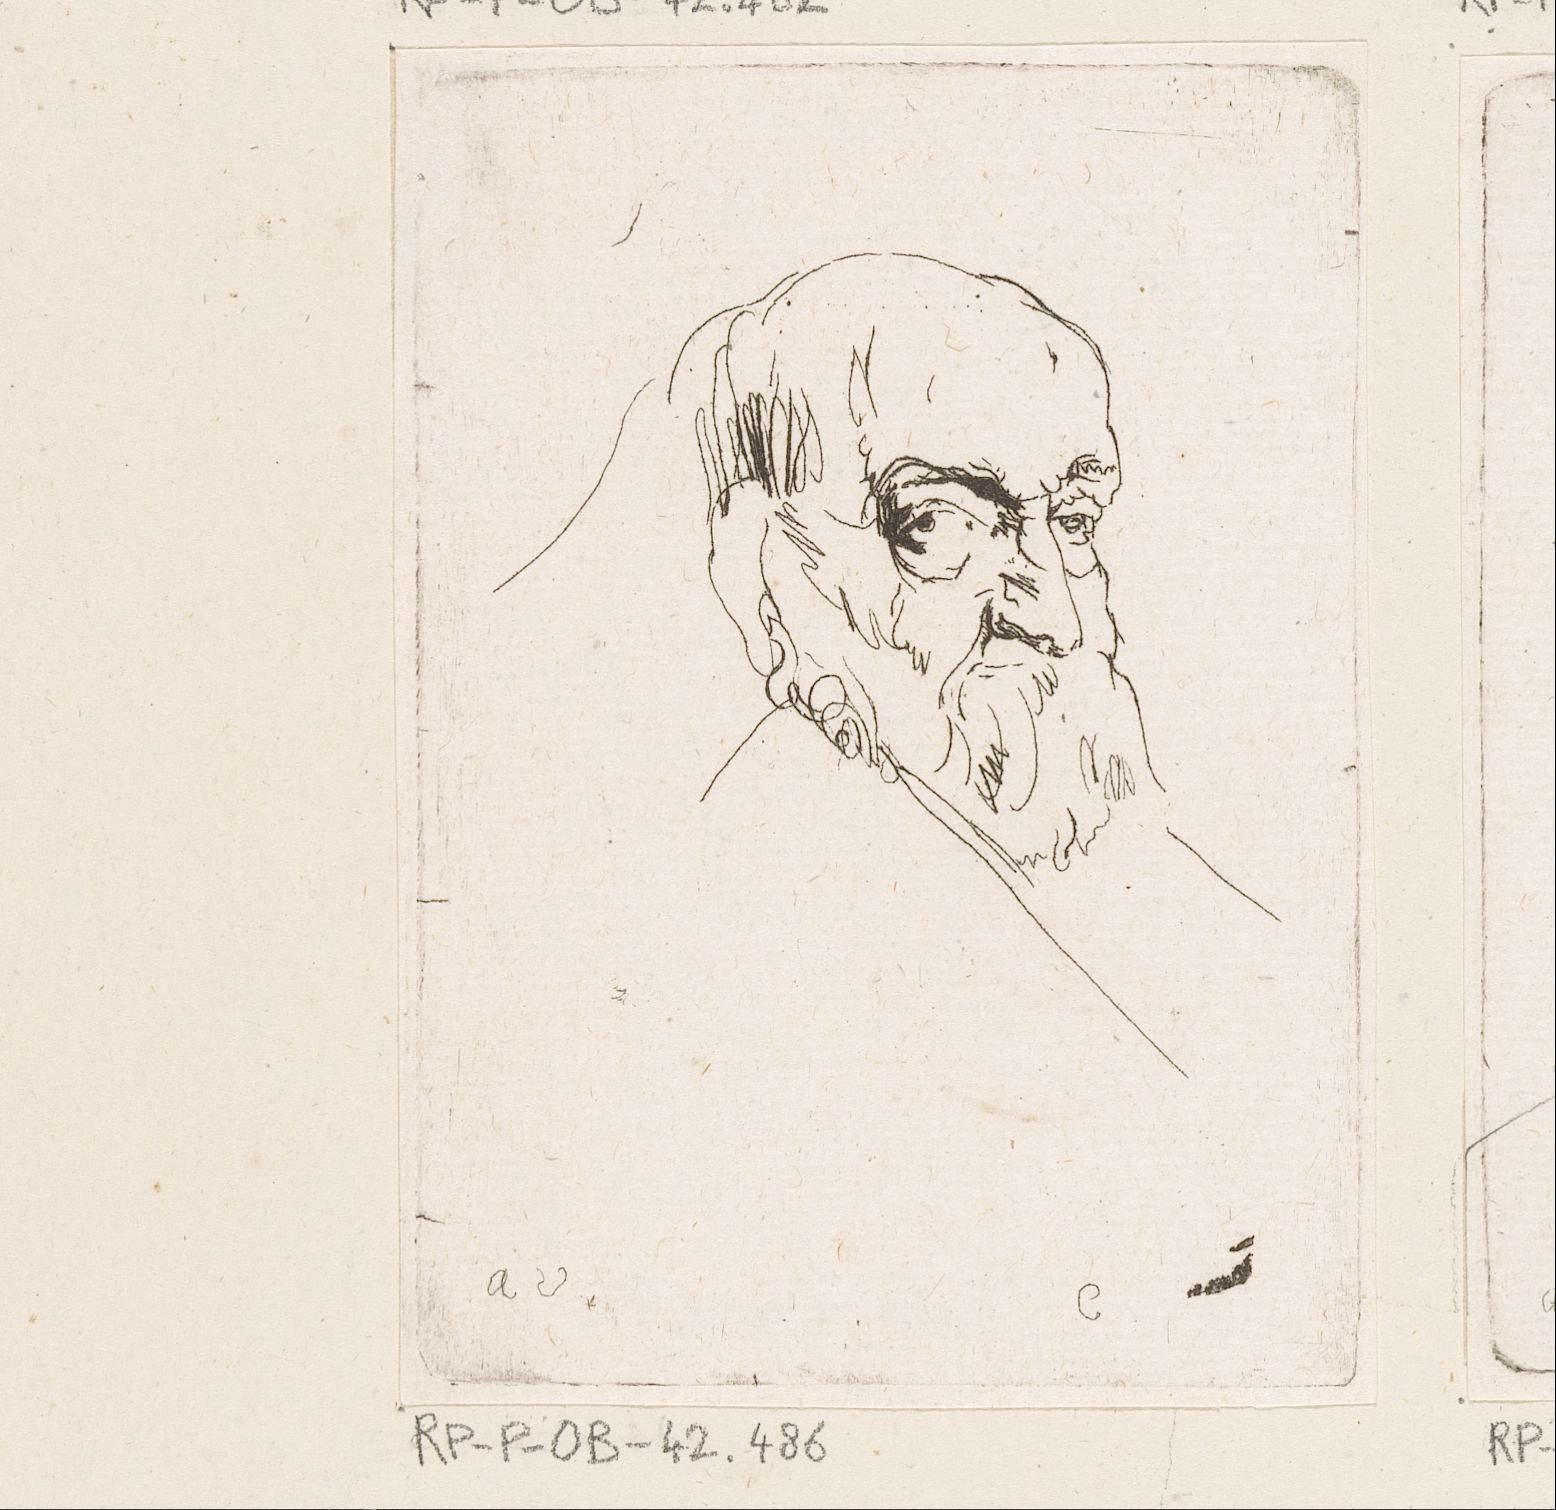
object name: print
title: Recueil de Testes d'Antoine Van Dyck (...)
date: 1735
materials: paper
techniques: etching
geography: france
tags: head (human), old man, beard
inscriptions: collector's mark: Lugt 240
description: Prent uit een serie van 31 prenten naar getekende hoofden door Van Dyck, plus een titelprent naar Bouchardon, getiteld: "Recueil de Testes d'Antoine Van Dyck tirées du Cabinet de M. Crozat et gravées par M. le C. de C.".